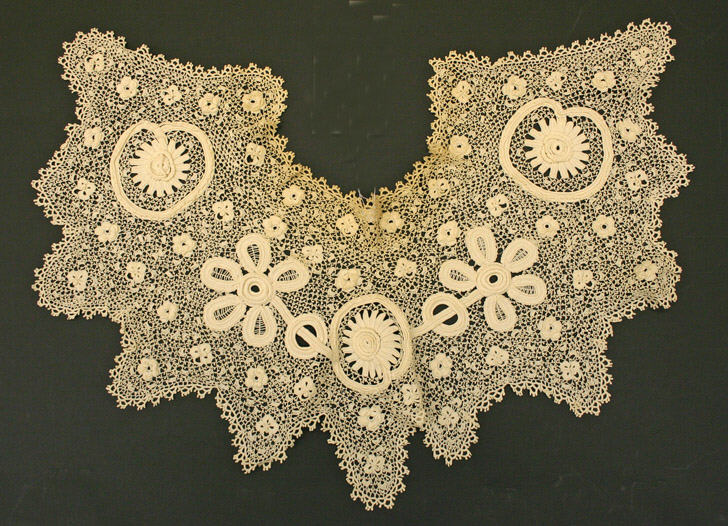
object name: collar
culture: american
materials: cotton